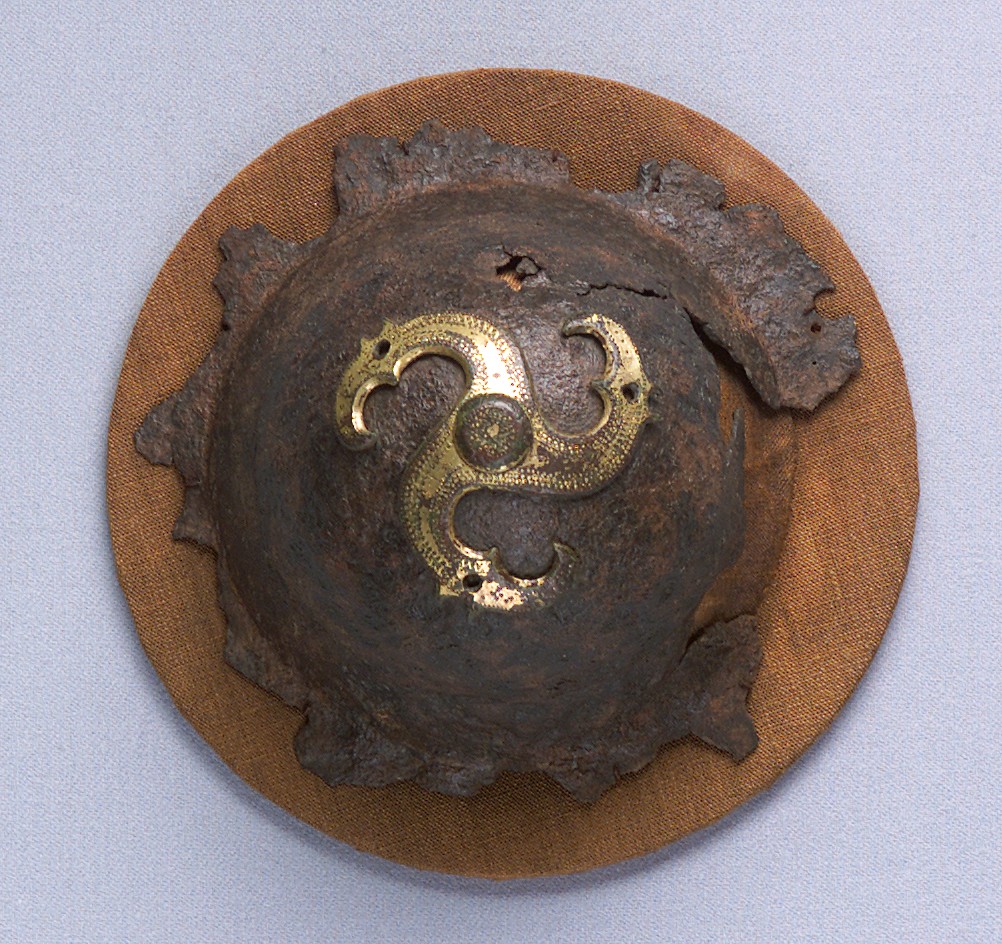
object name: shield bos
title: Shield Boss (Umbo)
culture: western european, langobardic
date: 601-700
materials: copper alloy, gold, iron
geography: italy